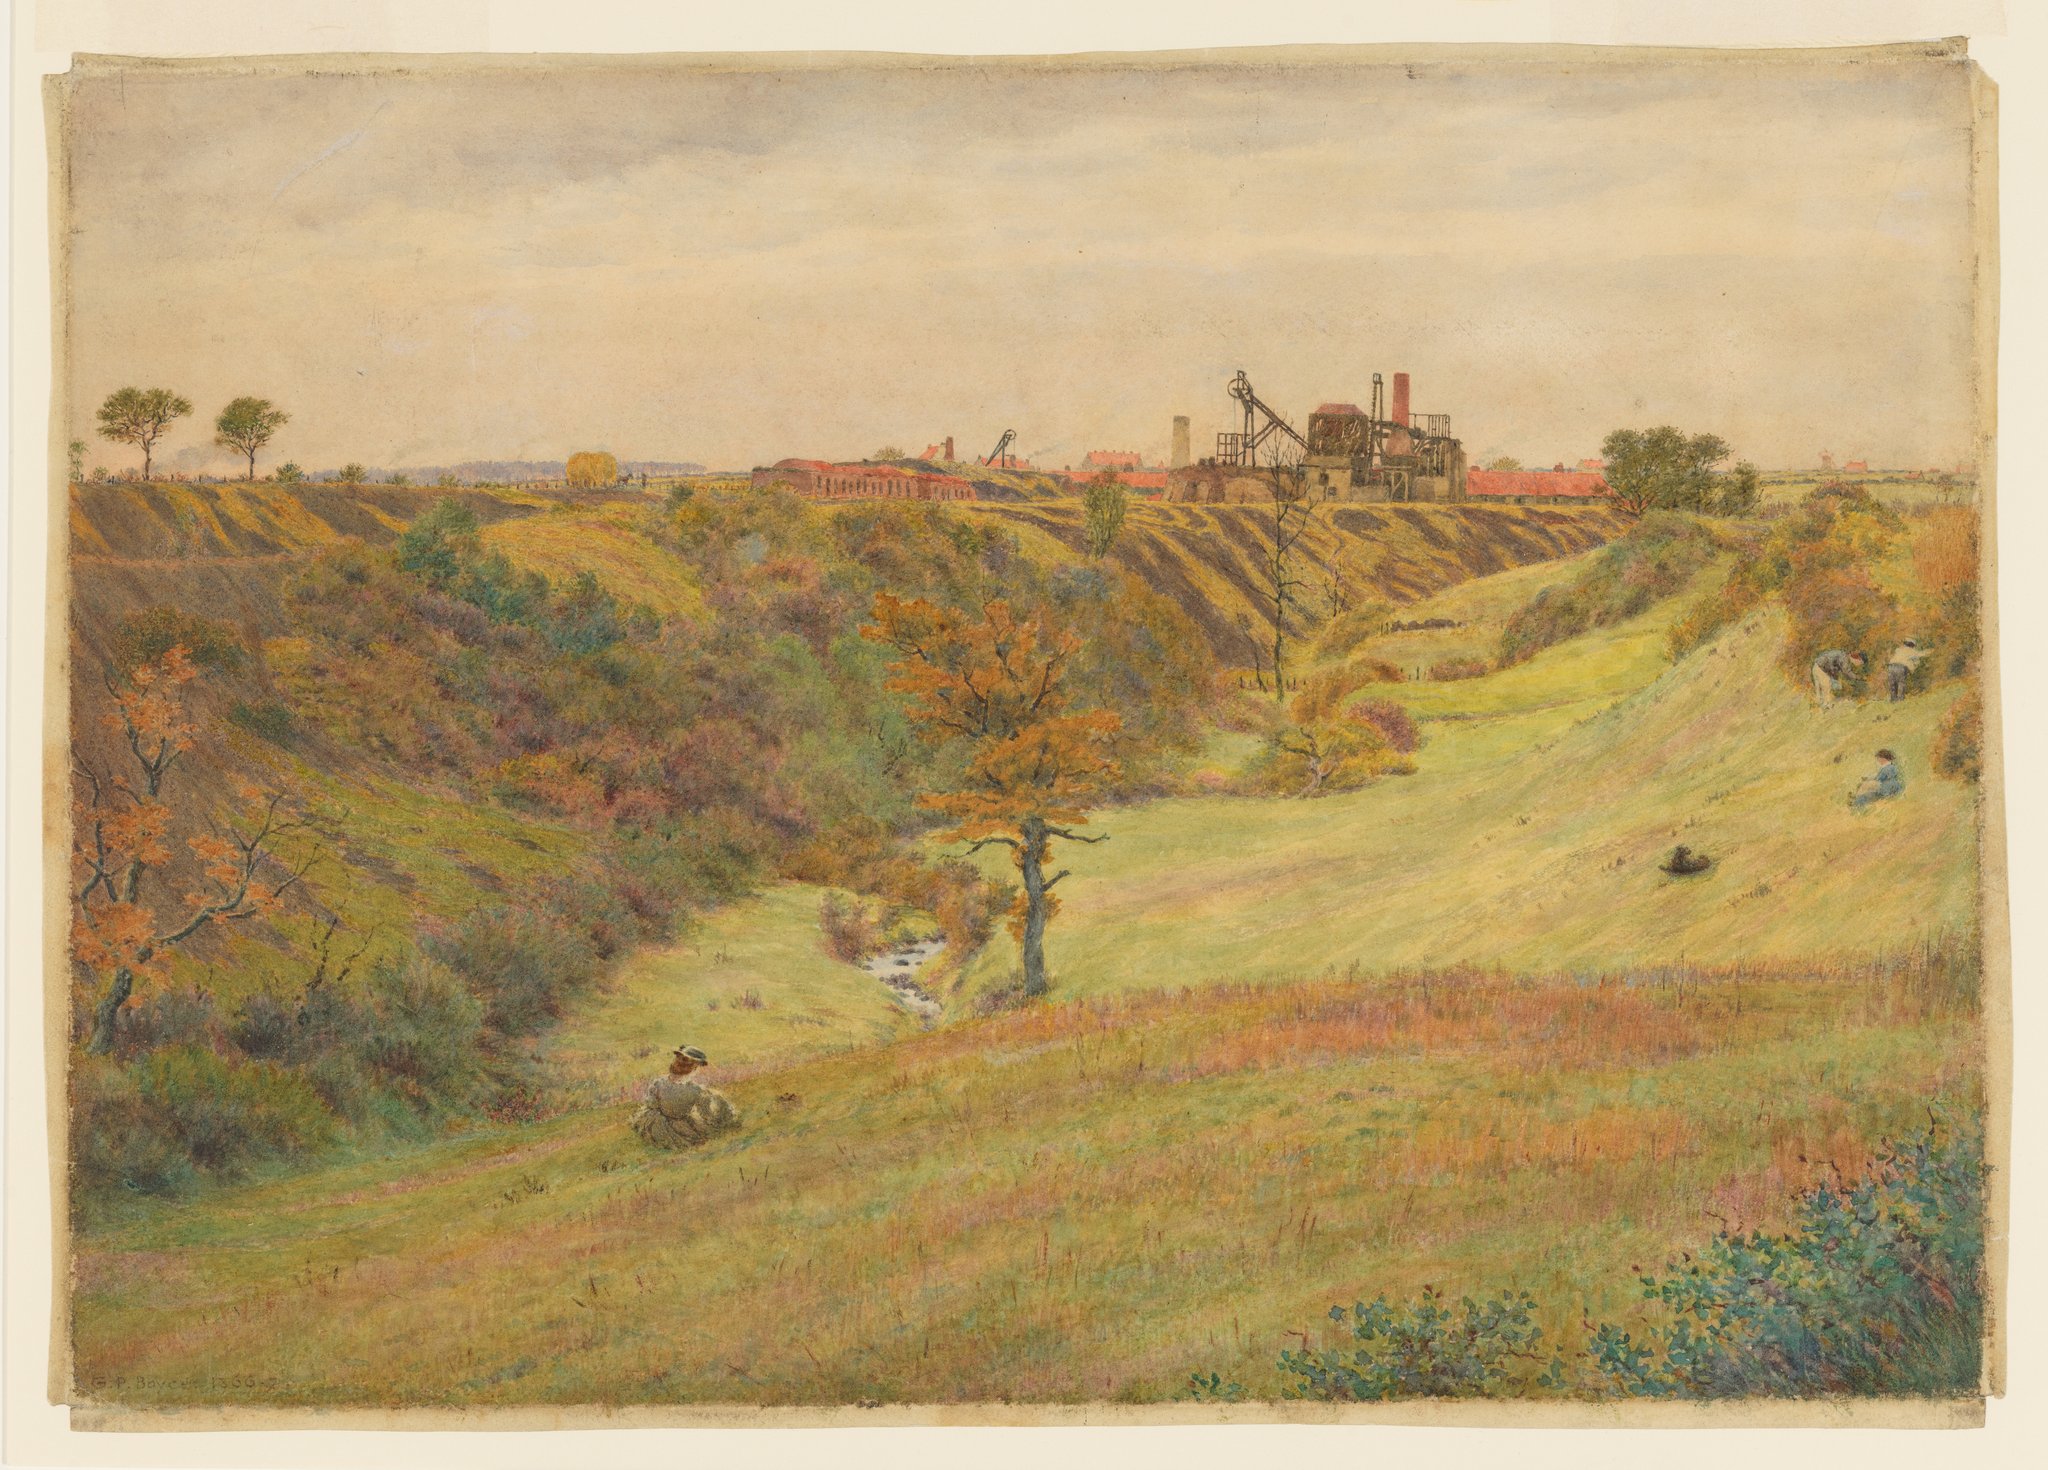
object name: drawing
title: Autumn landscape with a colliery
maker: george price boyce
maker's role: artist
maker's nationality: british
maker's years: 1826-1897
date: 1866-1867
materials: gouache, watercolor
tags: landscapes,industry